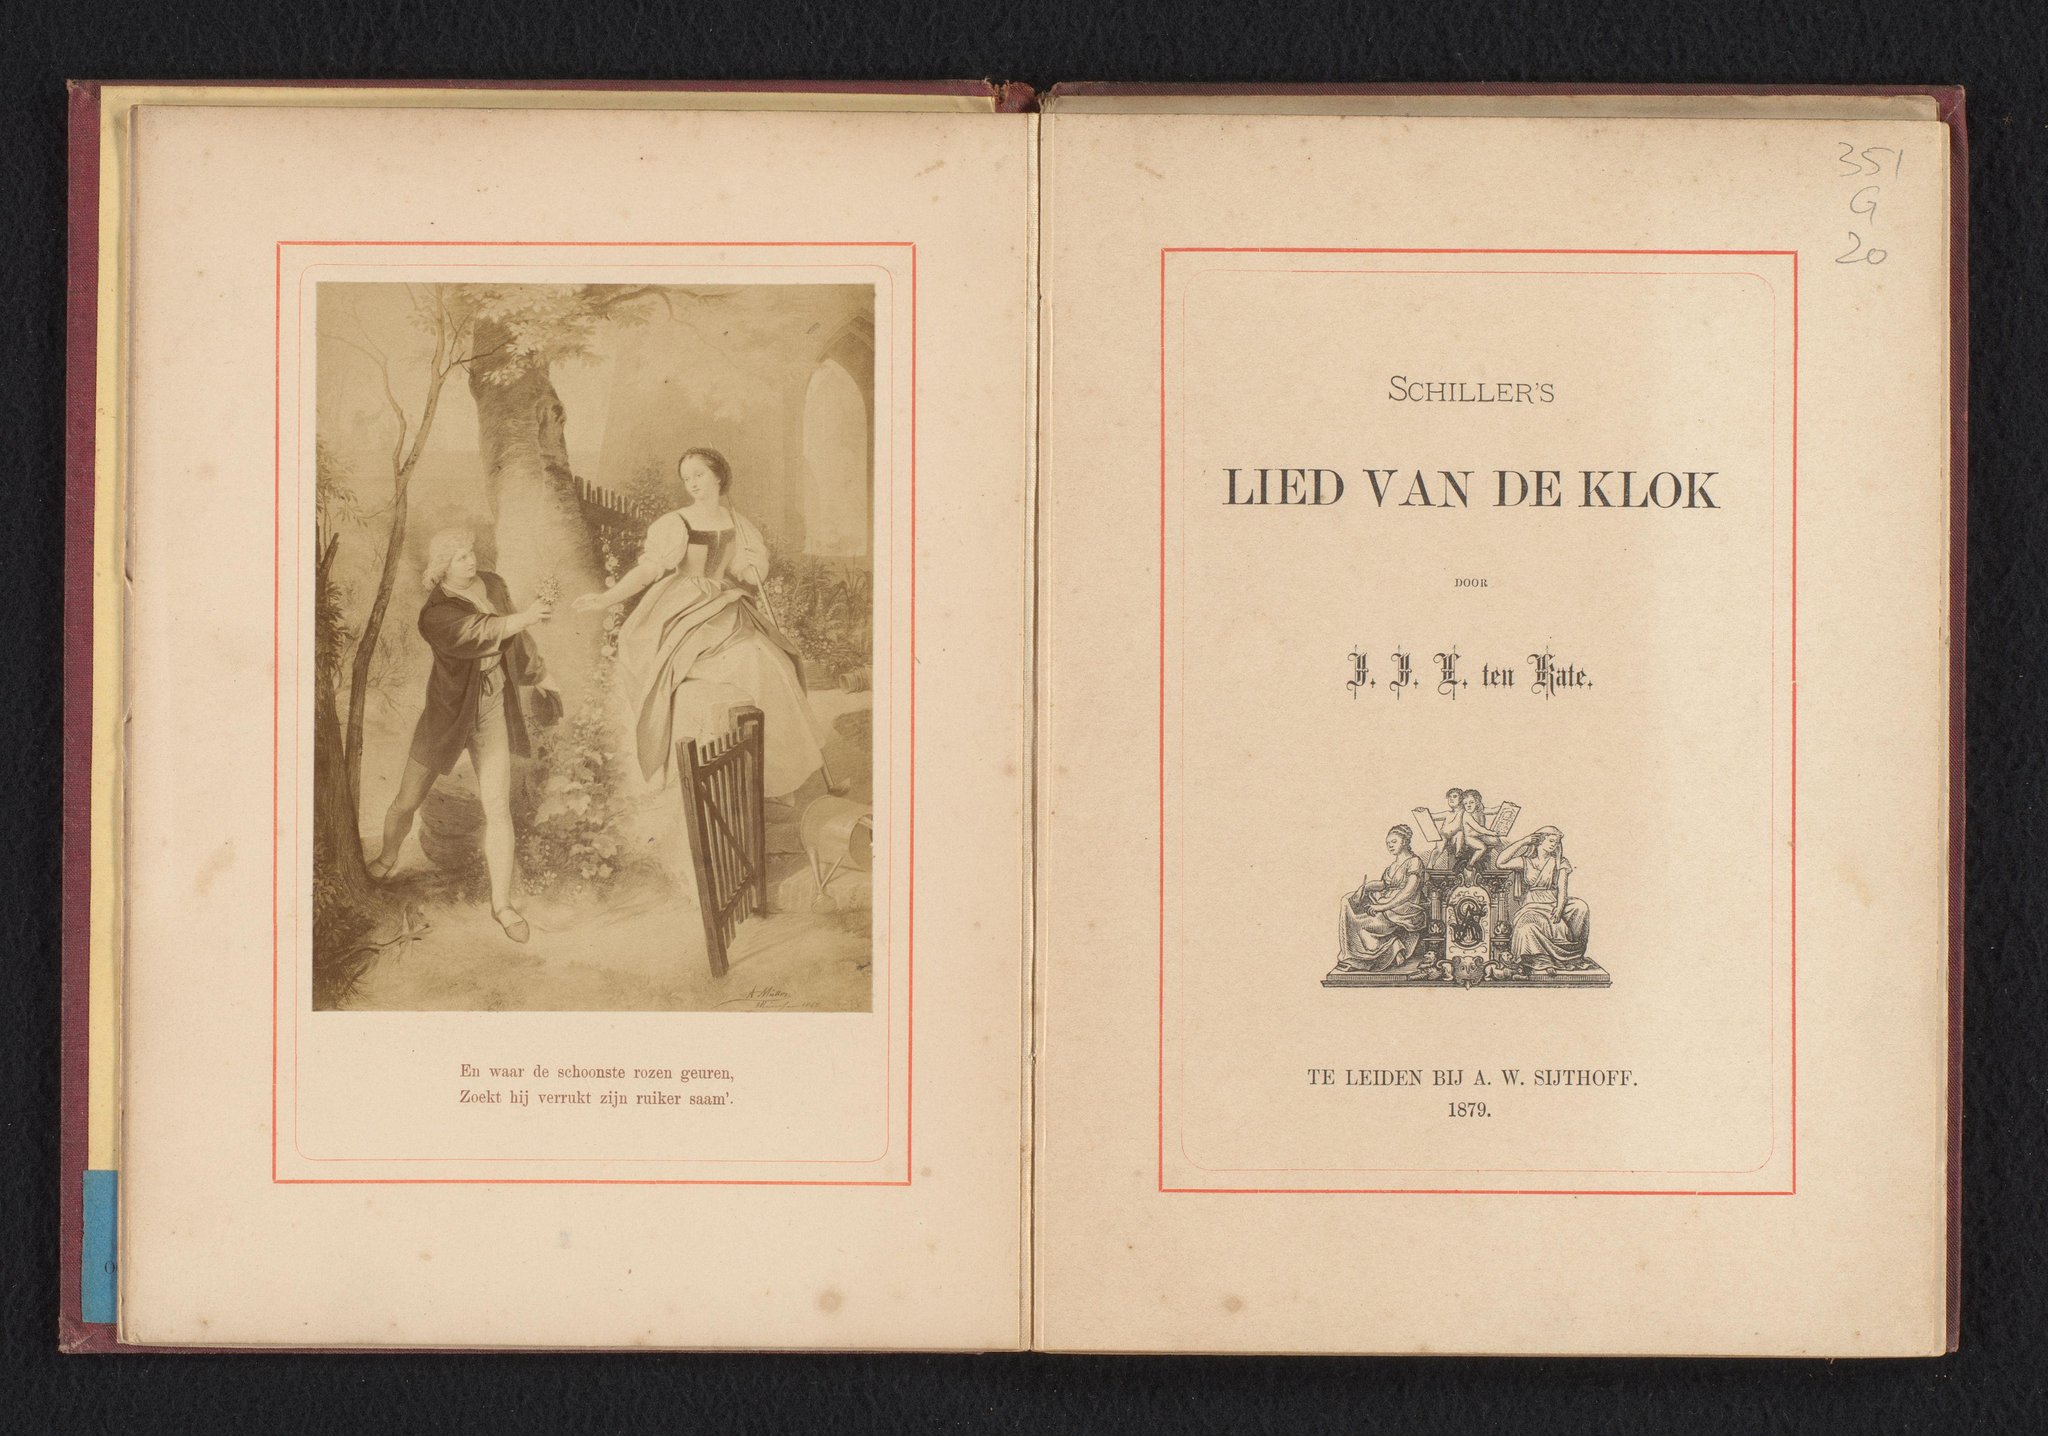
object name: photograph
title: Fotoreproductie van een schilderij van een jonge man die een klein bos bloemen geeft aan een jonge vrouw door Andreas Müller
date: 1874-1879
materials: paper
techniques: albumen print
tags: cut flowers; nosegay, bunch of flowers, picture, painting, couple of lovers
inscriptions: inscription: ‘En waar de schoonste rozen geuren,/ Zoekt hij verrukt zijn ruiker saam!’